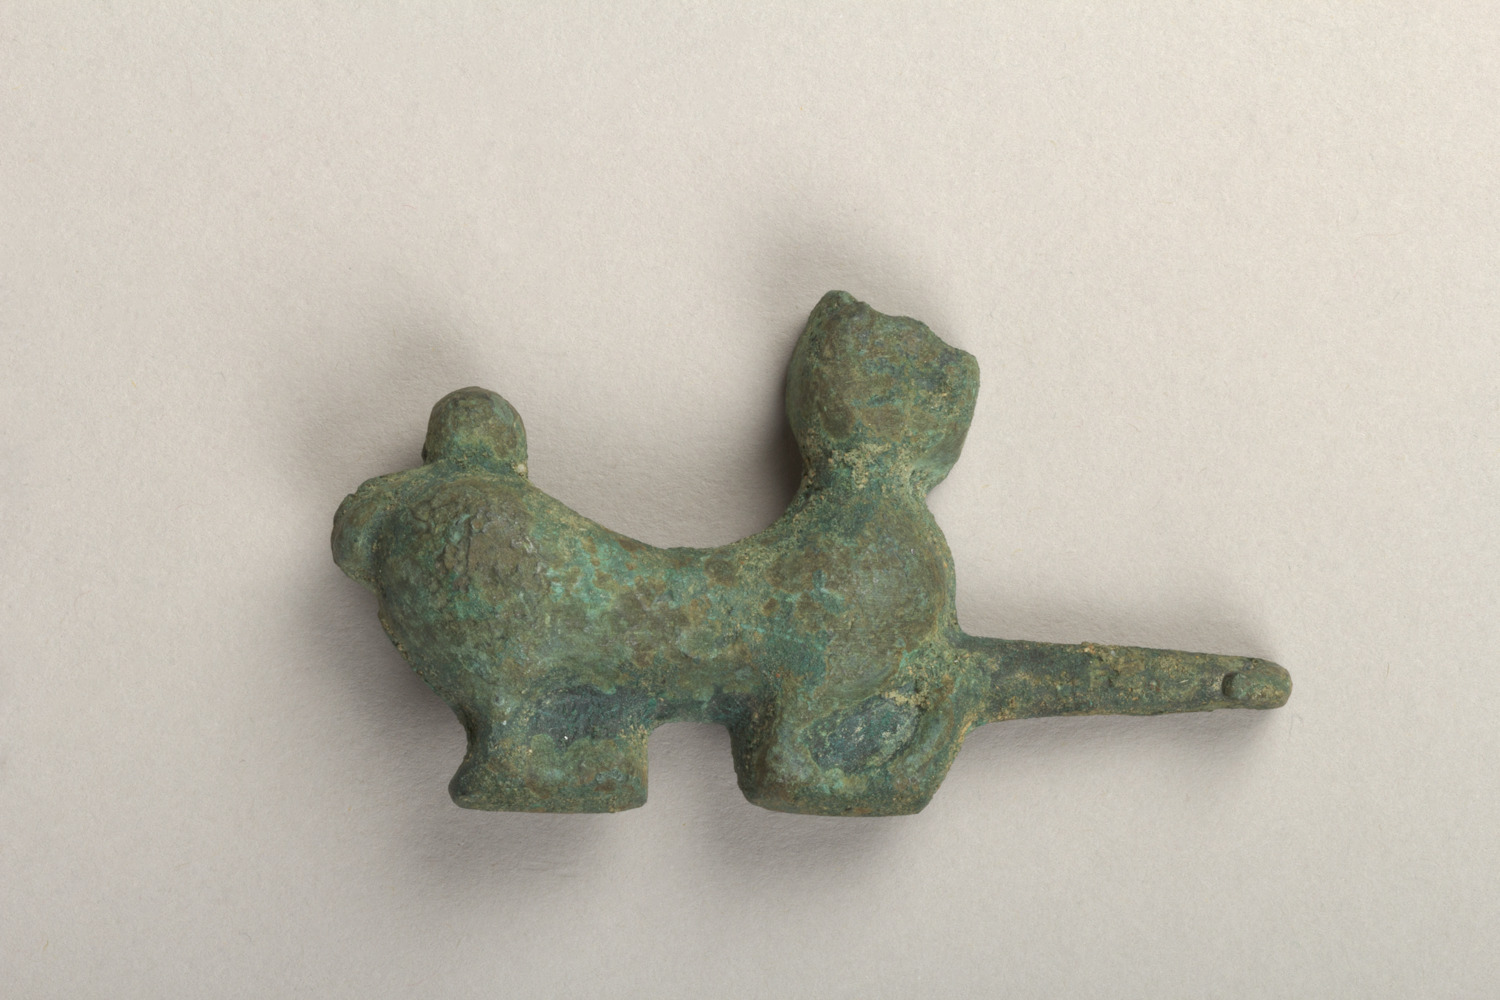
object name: belt buckle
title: Feline-shaped belt buckle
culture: korean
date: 201-300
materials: bronze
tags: animals